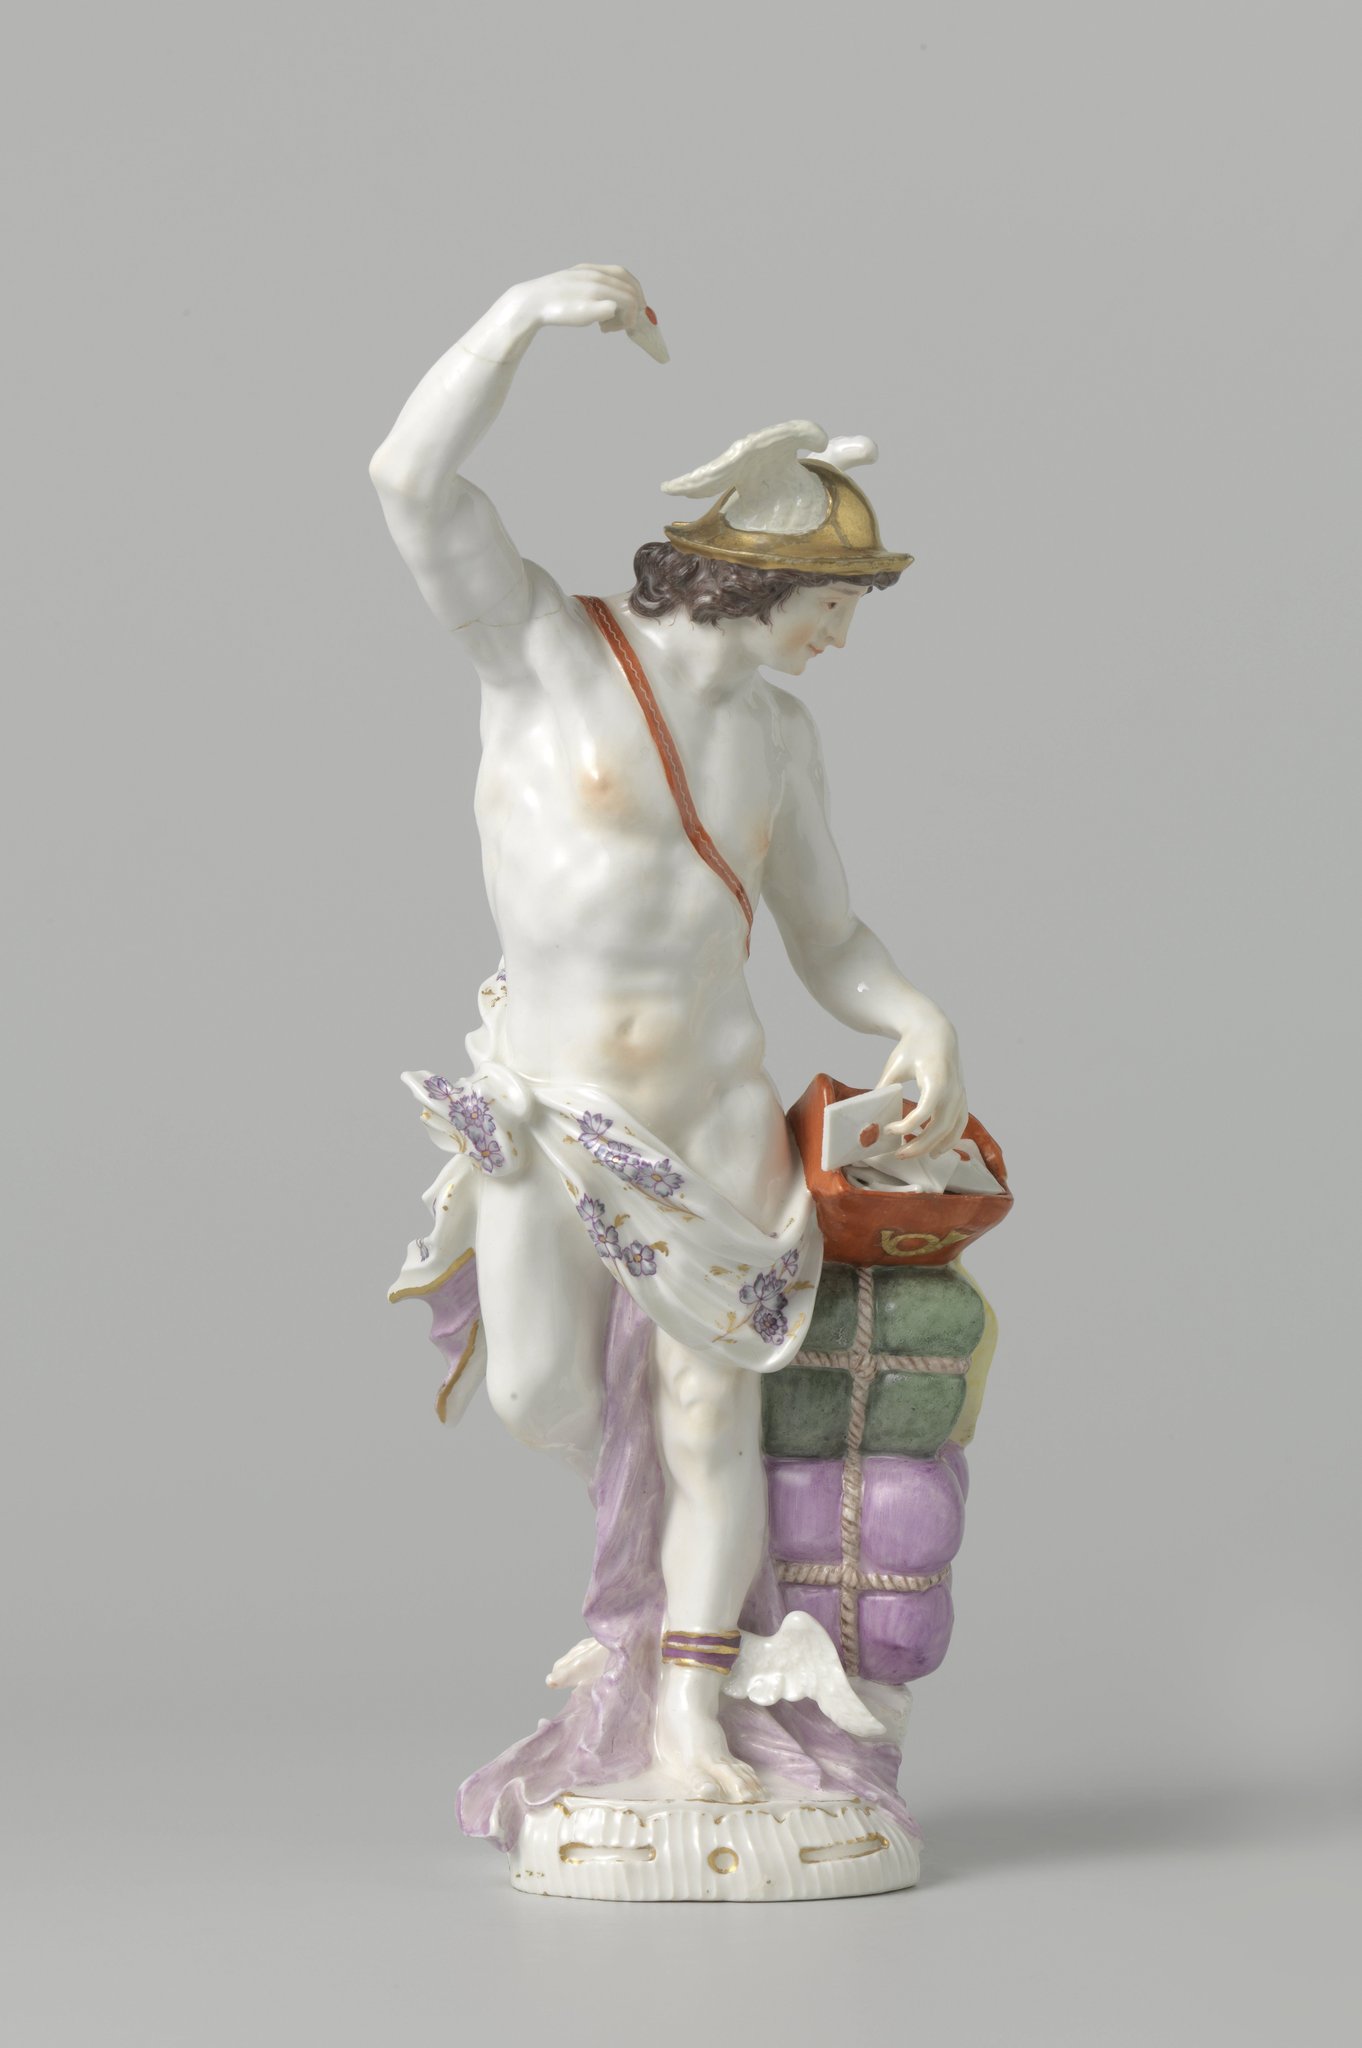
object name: figure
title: Figure of Mercury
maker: wilhelm caspar wegely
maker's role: porcelain company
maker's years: 1714-1764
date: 1752-1757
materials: glaze, gold, porcelain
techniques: firing, forming, gilding, vitrification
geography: berlin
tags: (story of) mercury (hermes), letter, envelope, parcel, packet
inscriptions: mark: ‘1/ 66/ 3/ W’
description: porcelain factory of Wilhelm Caspar Wegely (1714–1764) Berlin, c. 1752–1757 hard-paste porcelain